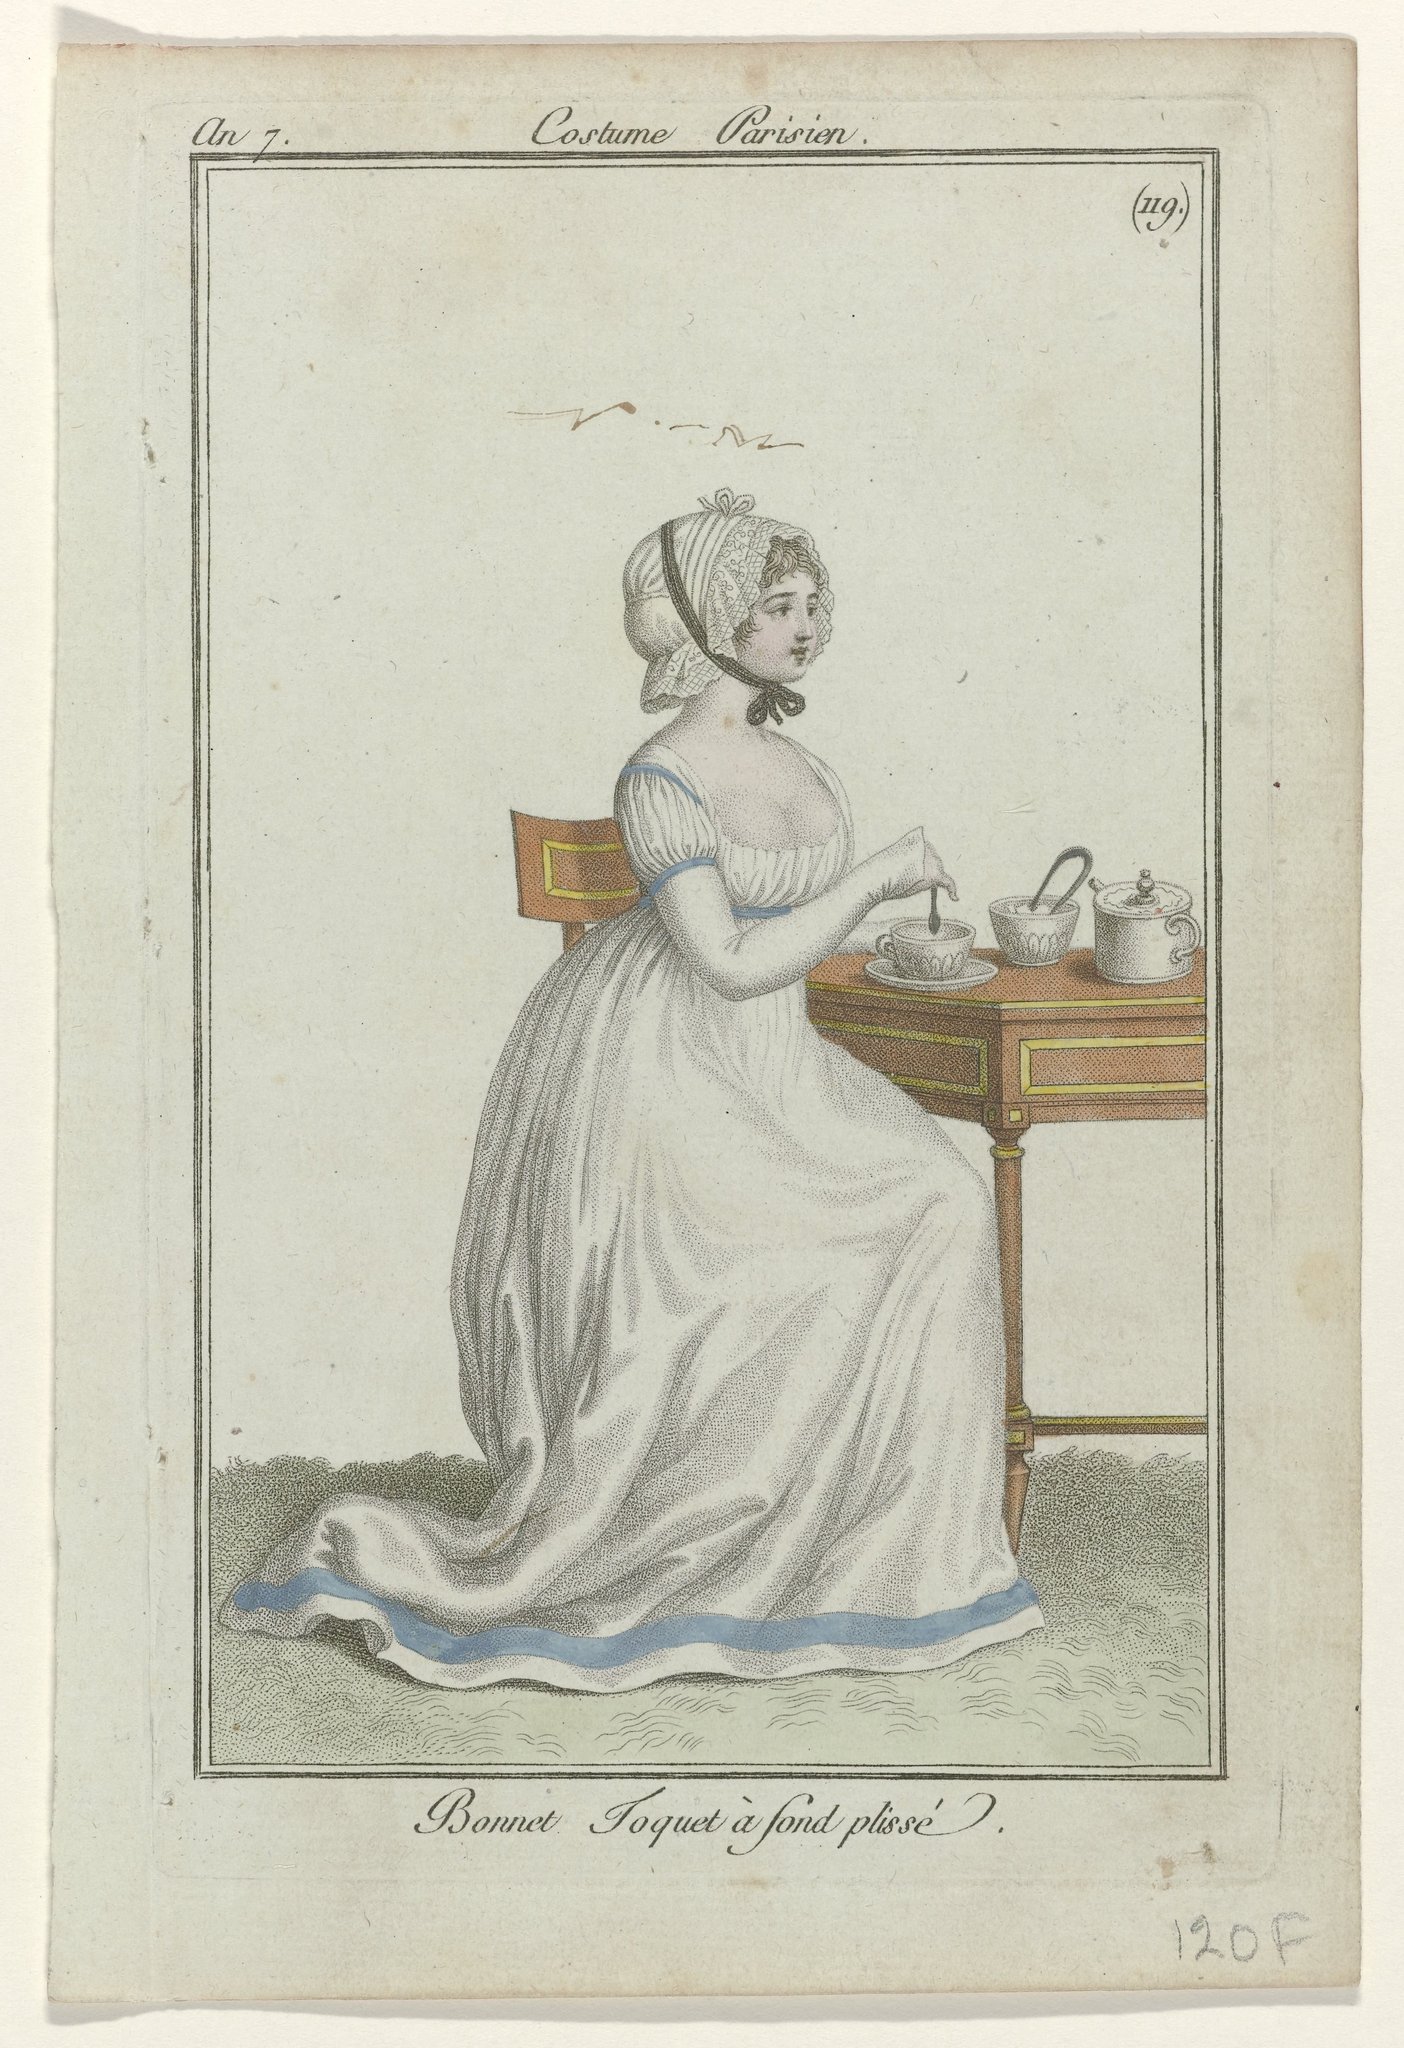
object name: fashion print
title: Journal des Dames et des Modes, Costume Parisien, 1799, An 7 (119) : Bonnet Toquet (...)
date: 1799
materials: paper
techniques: engraving, hand coloring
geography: paris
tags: head-gear: cap (+ women's clothes), fashion plates, dress, gown (+ women's clothes), table, chair, tea- and coffee-service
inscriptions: title: ‘Costume Parisien.’, caption: ‘Bonnet Toquet à fond plissé.’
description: 'Bonnet-Toquet' met geplooide bol. Japon met lange mouwen en hoge taille. De prent maakt deel uit van het modetijdschrift Journal des Dames et des Modes, uitgegeven door Pierre de la Mésangère, Parijs, 1797-1839.